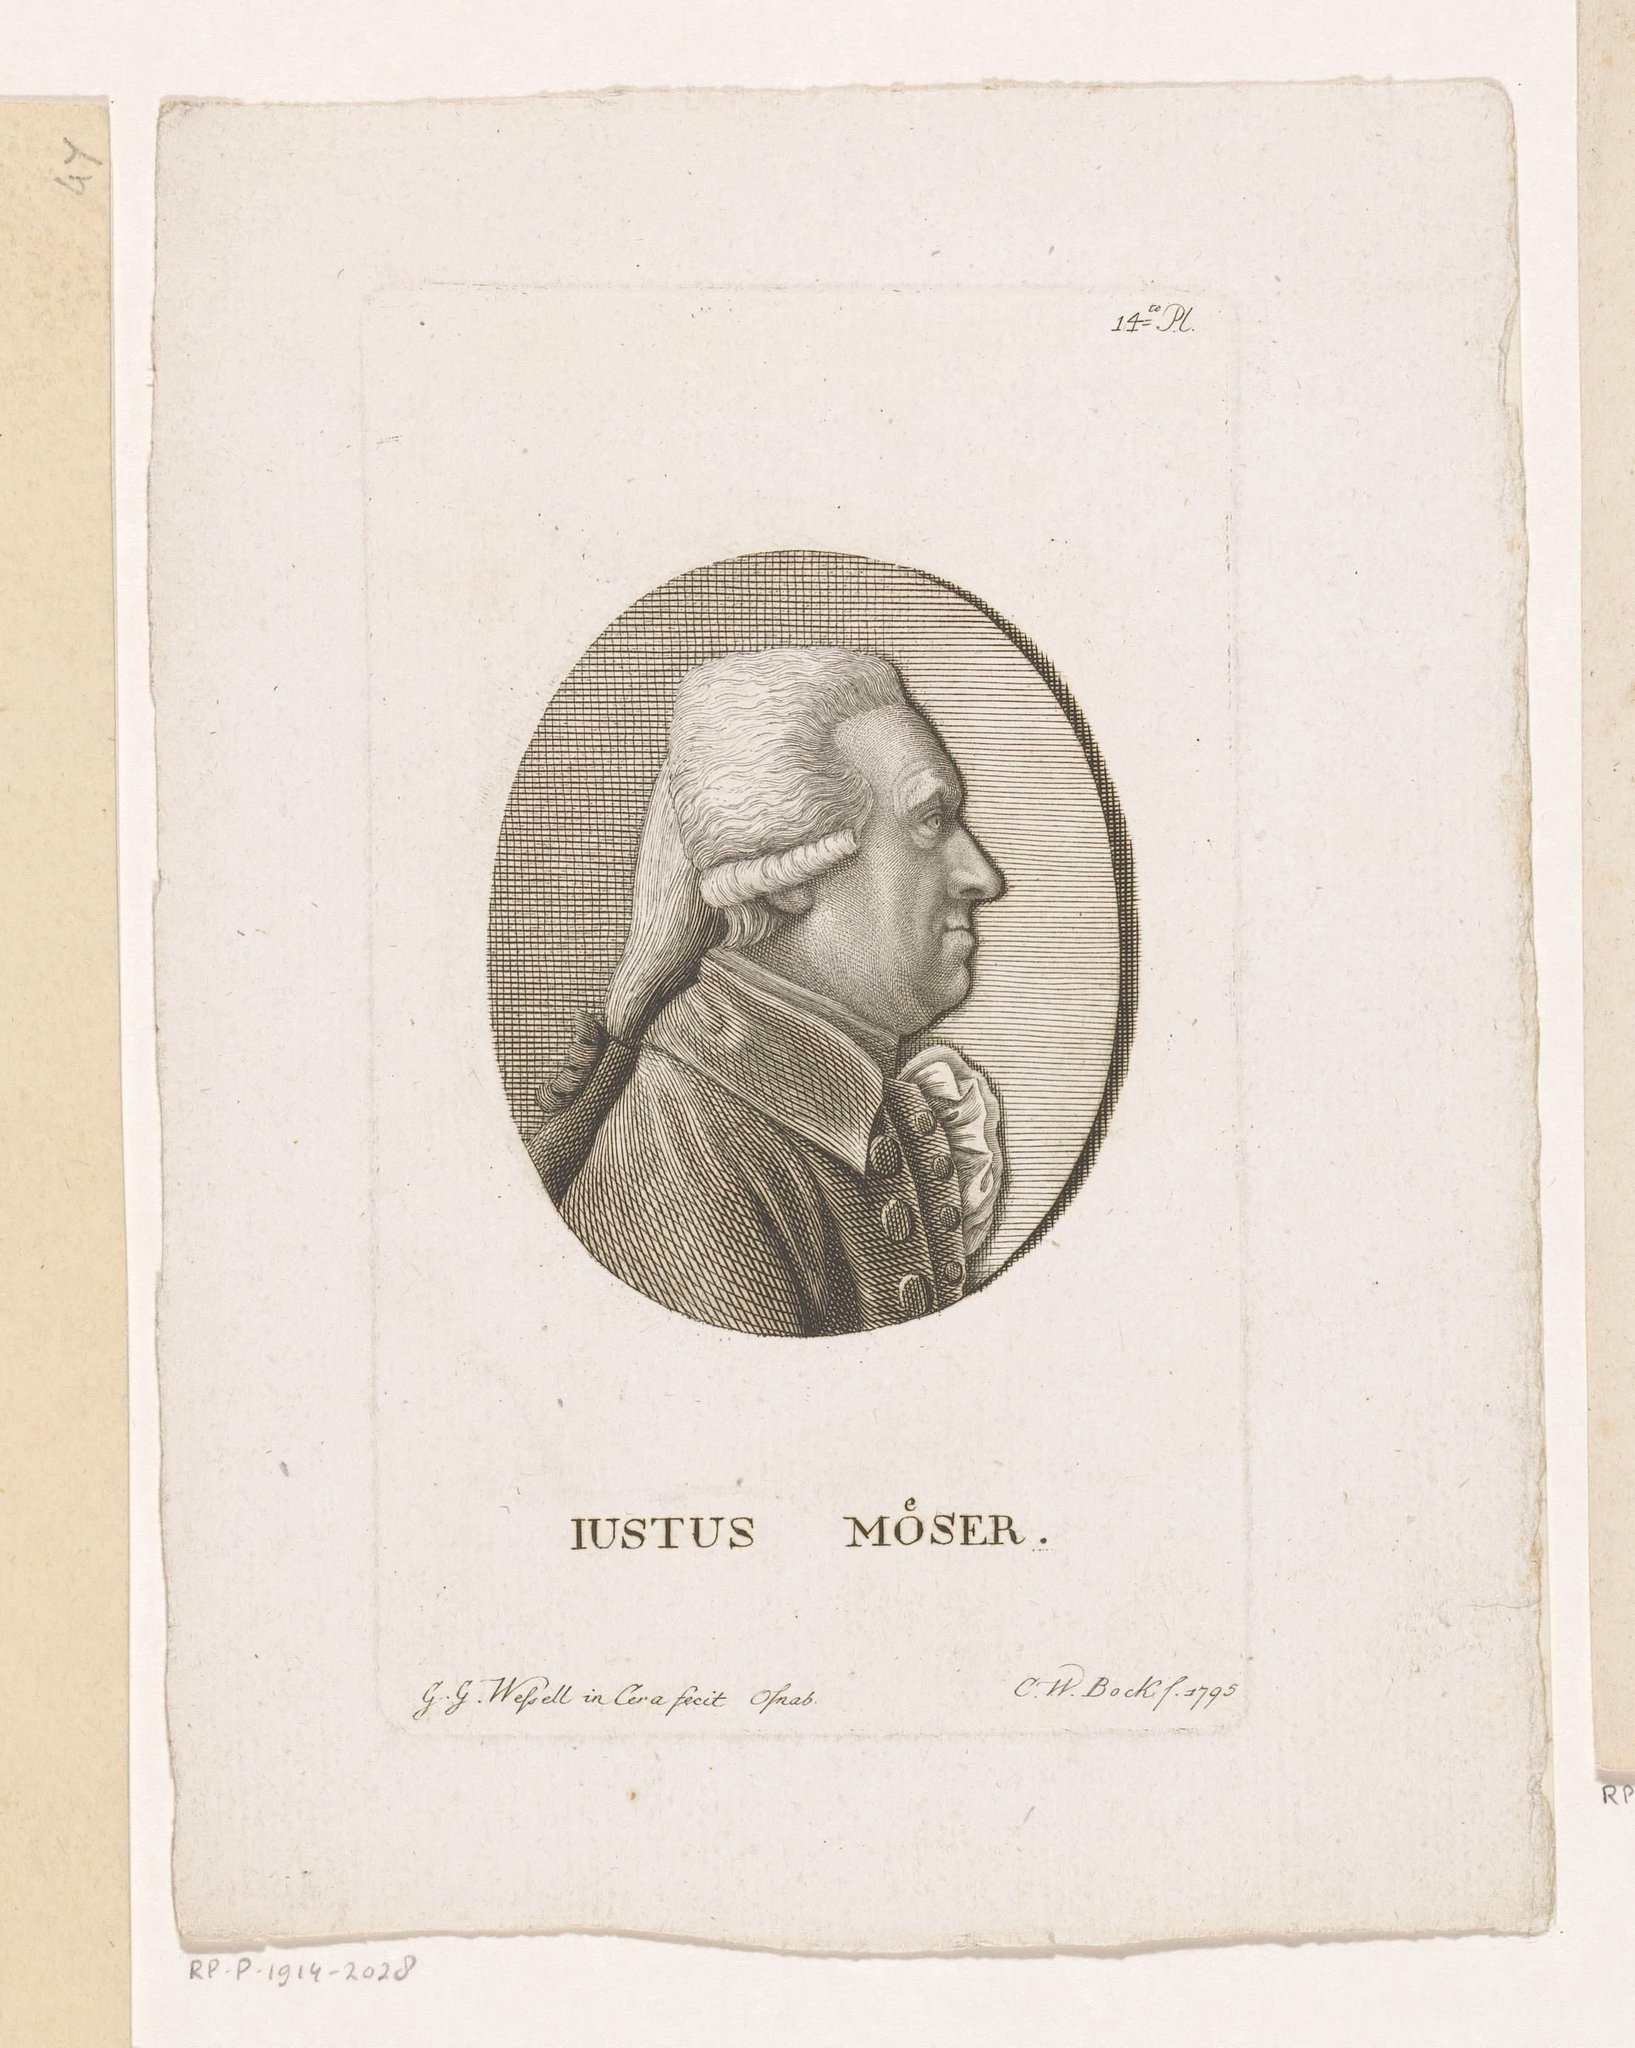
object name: print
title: Portret van Justus Möser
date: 1795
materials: paper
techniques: engraving, etching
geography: osnabrück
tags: historical persons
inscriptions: collector's mark: Lugt 2228